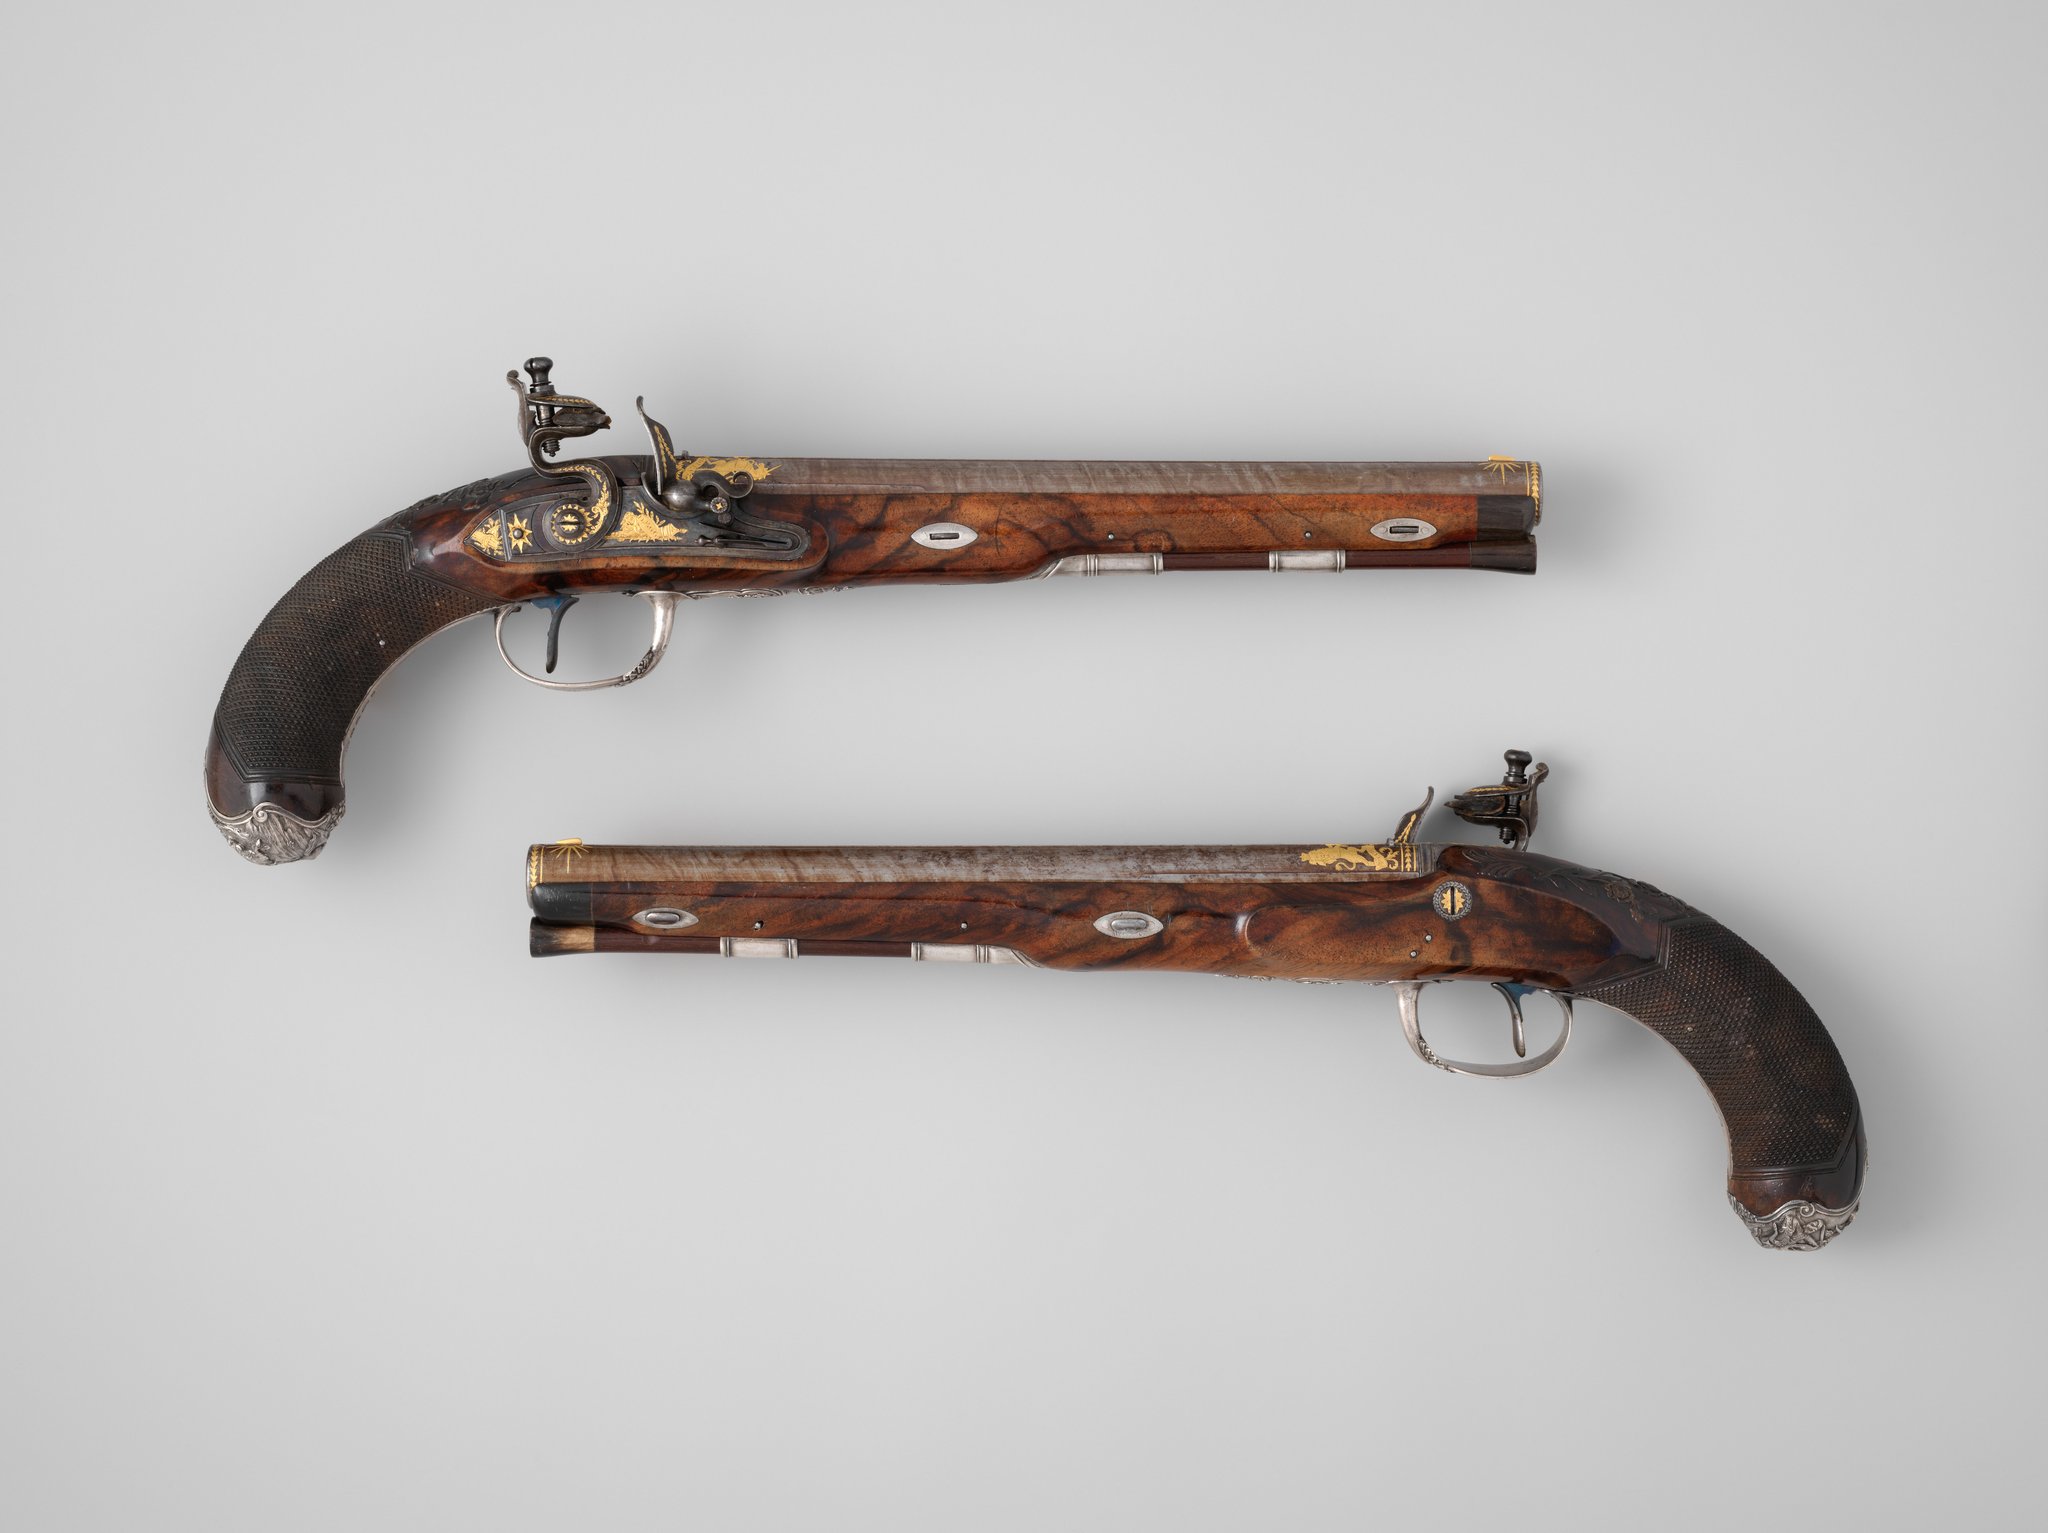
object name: flintlock pistol with case and accessory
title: Pair of Flintlock Pistols of the Prince of Wales, later George IV (1762–1830), with Case and Accessories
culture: british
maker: durs egg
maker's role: gunsmith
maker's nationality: swiss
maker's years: 1748-1831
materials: copper alloy, gold, horn, leather, silver, steel, textile, wood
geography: england